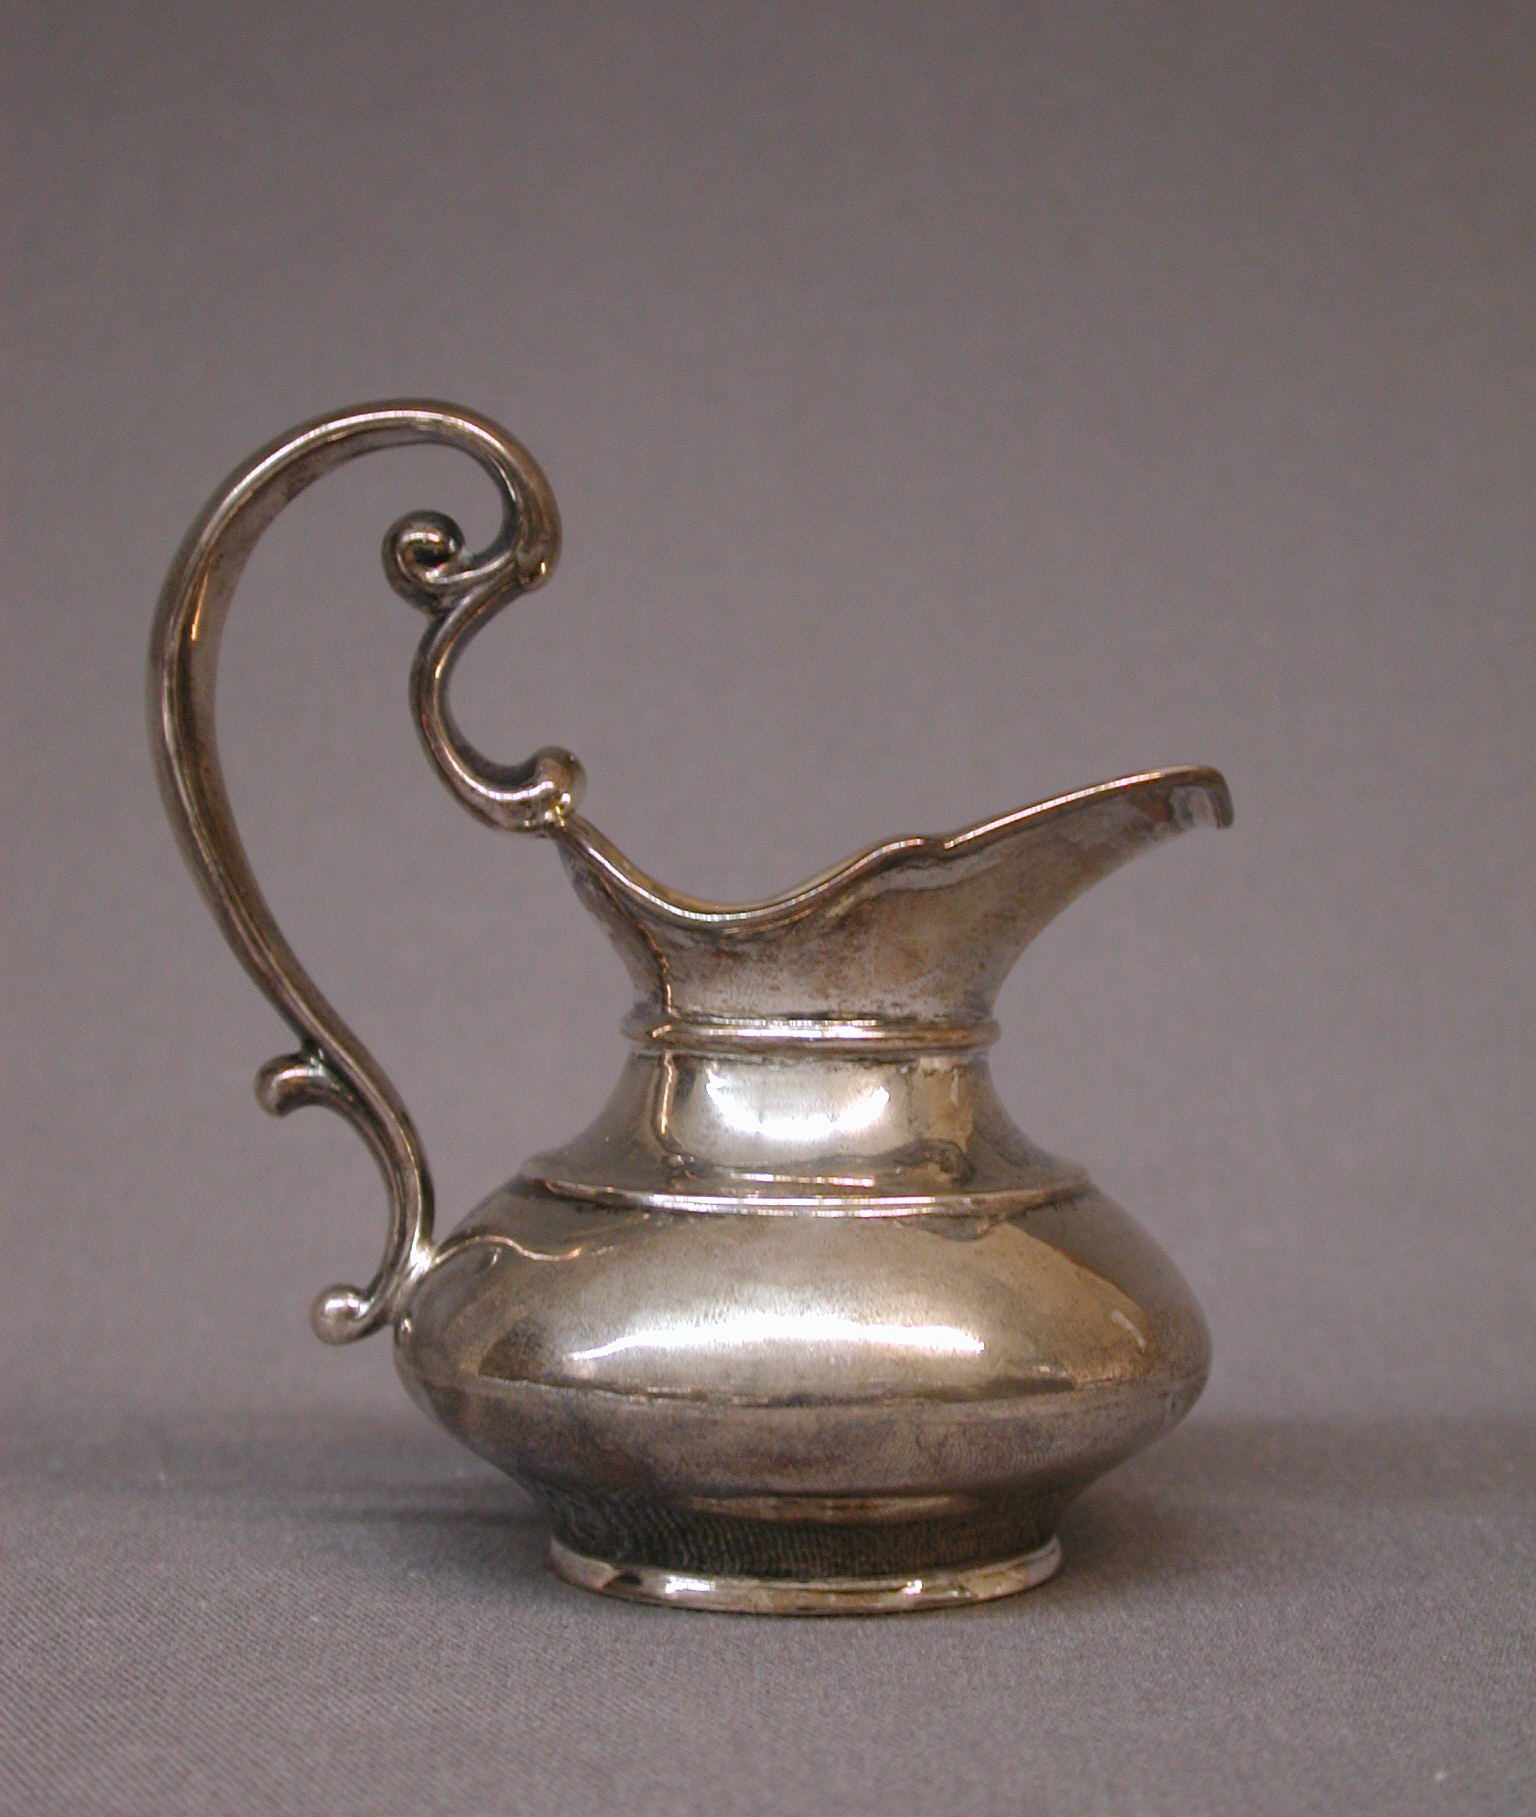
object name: jug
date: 1801-1900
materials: silver